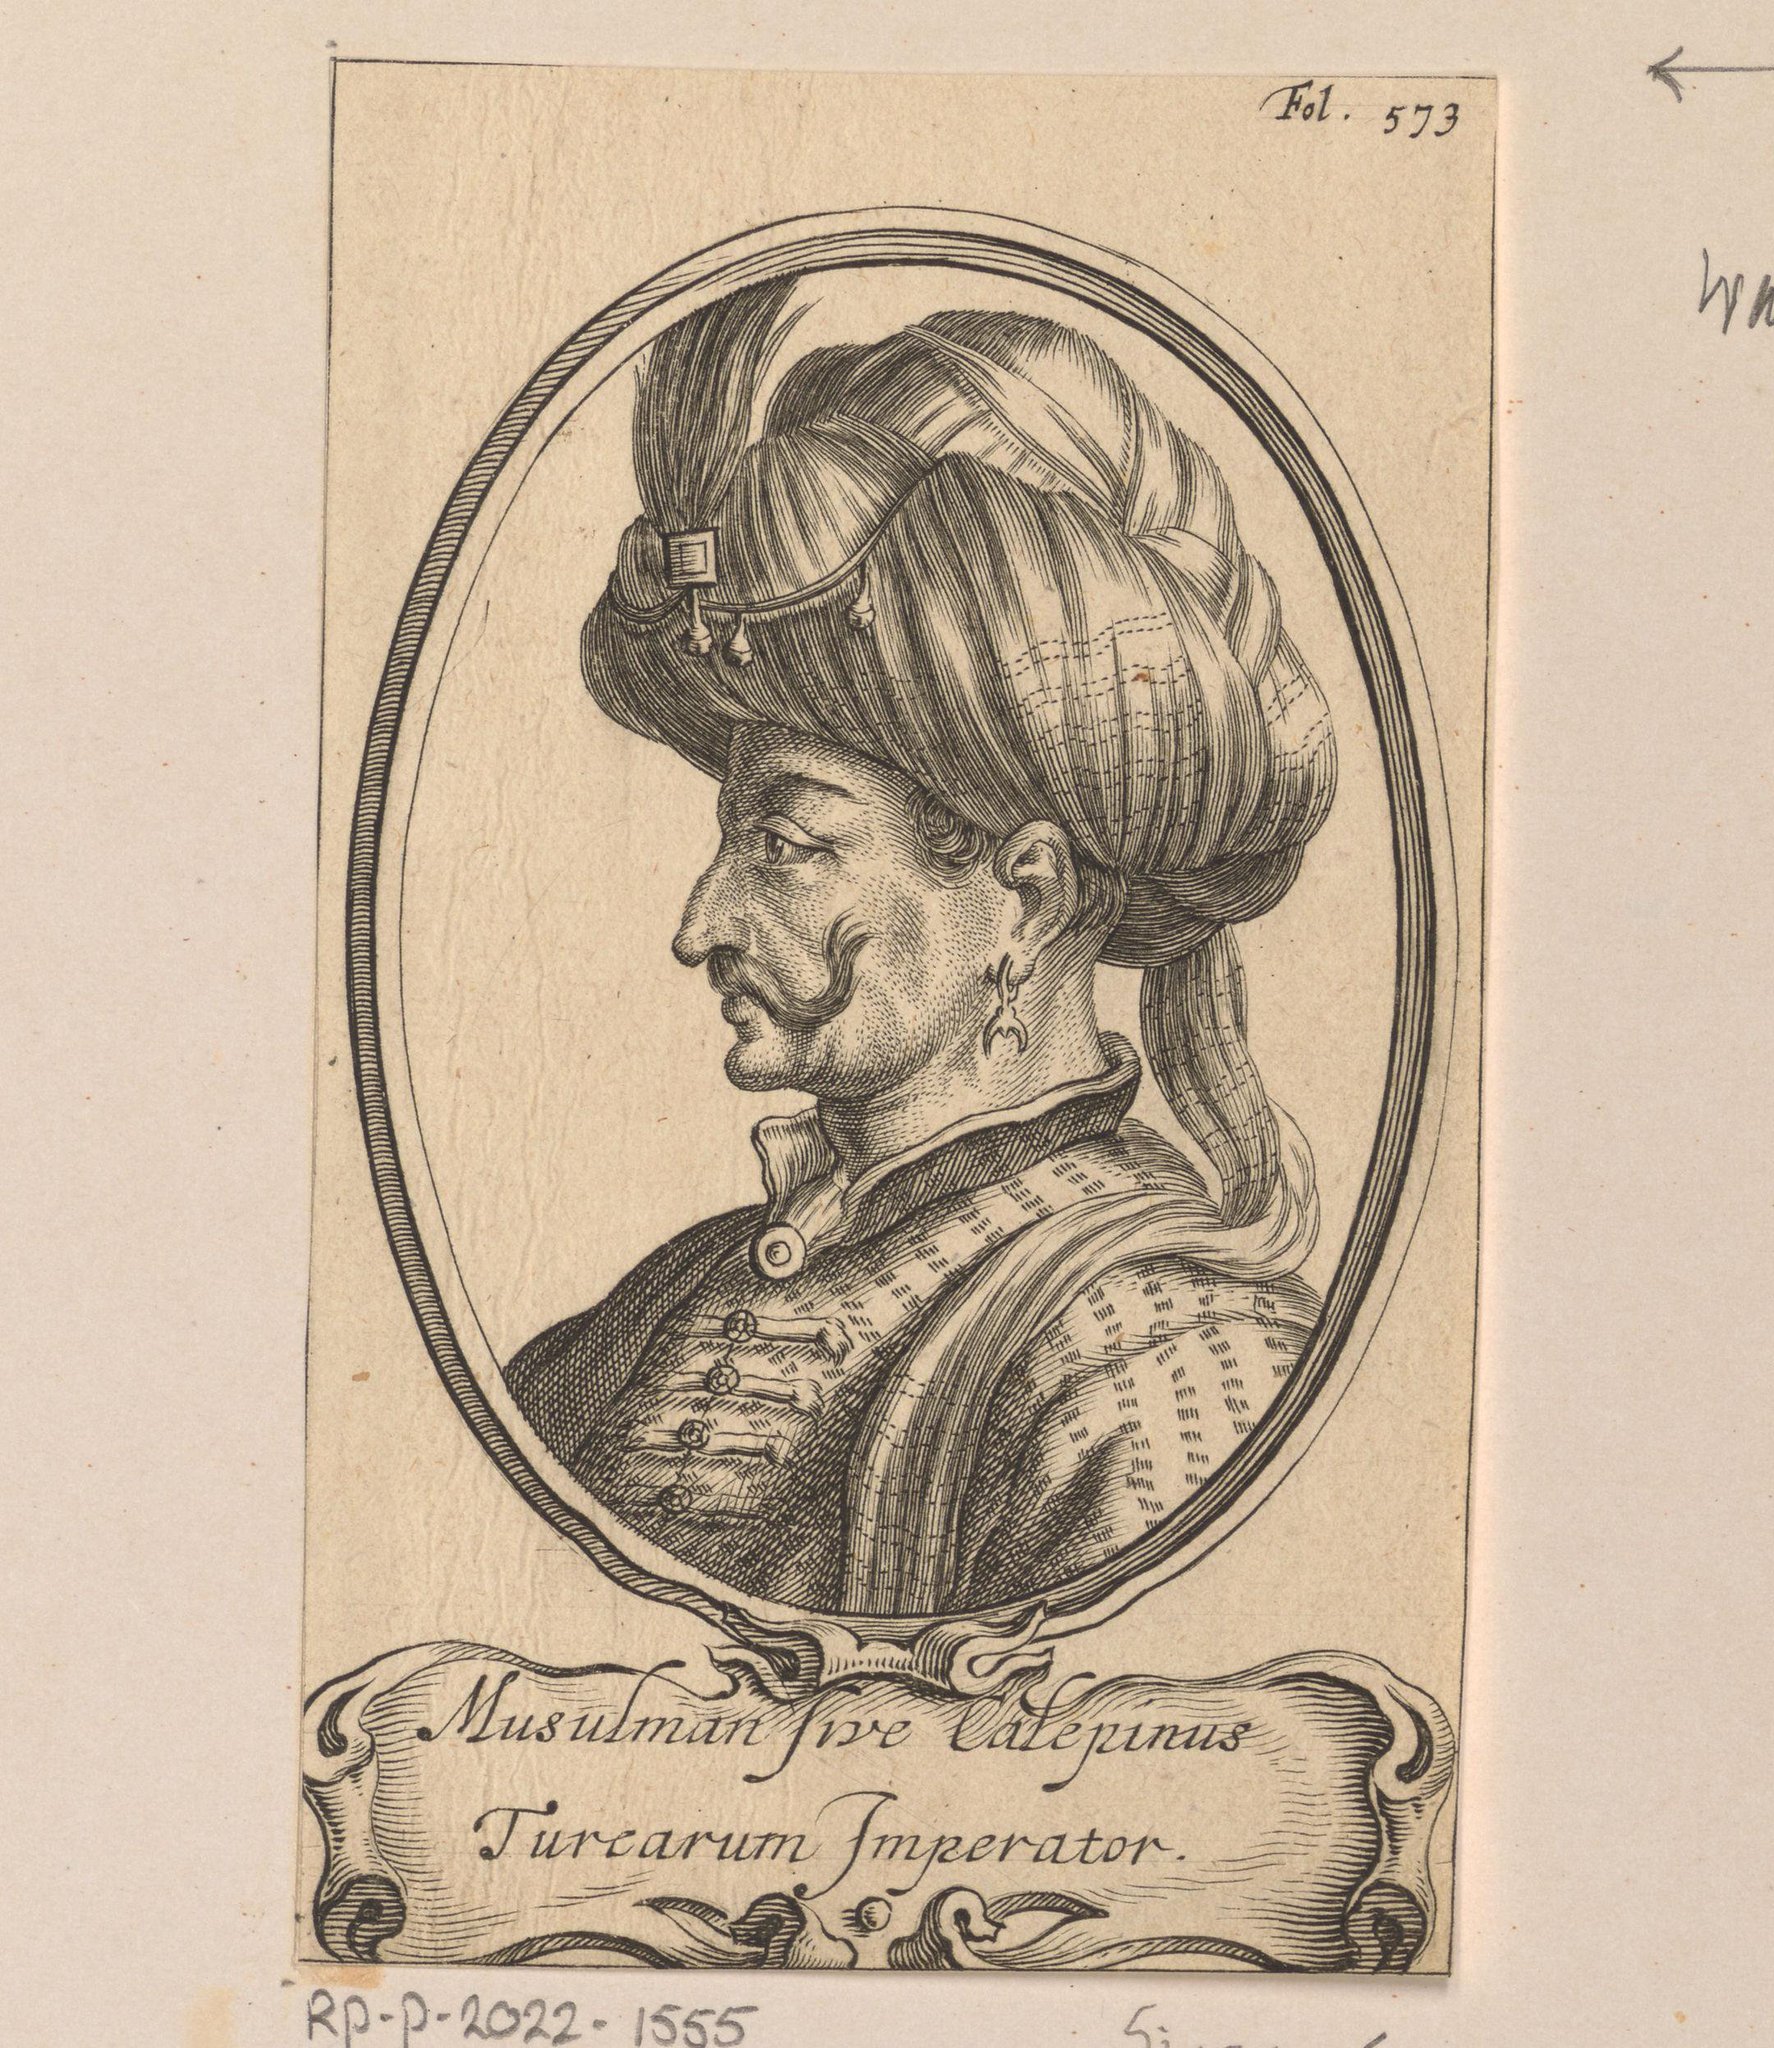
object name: book illustration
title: Portret van Süleyman Çelebi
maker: Anonymous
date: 1656-1659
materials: paper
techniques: engraving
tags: historical persons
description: Prent waarschijnlijk uit: Bos, Lambert van den. Het konincklyk treur-toonneel (...). Amsterdam: Jan Jacobsz. Schipper, [1656-1659], p. 573.